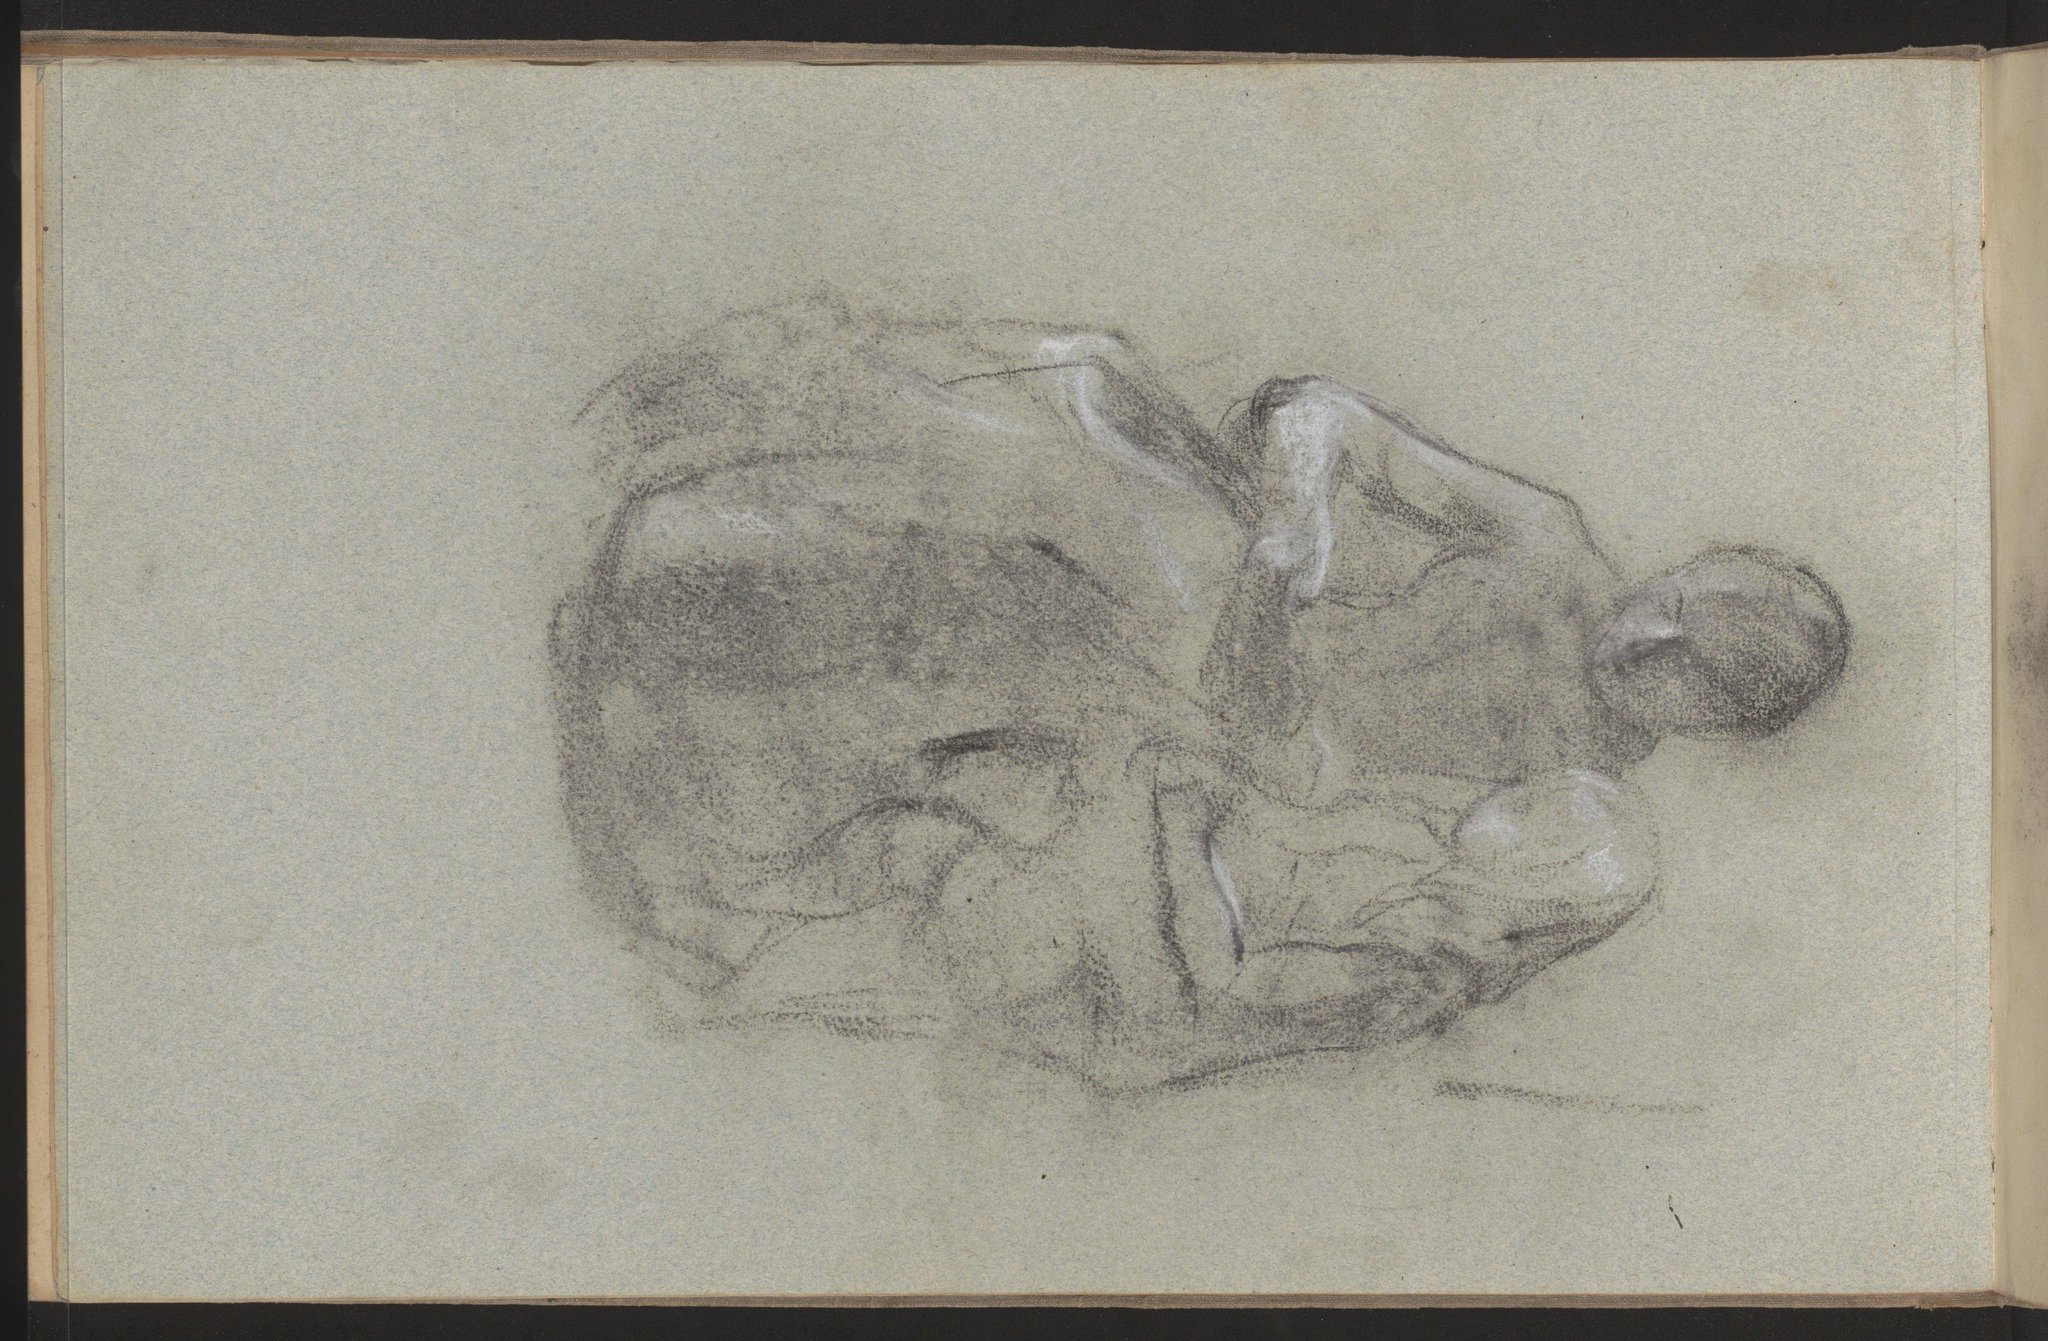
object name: sketchbook leaf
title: Moeder met een meisje op schoot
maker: albert neuhuys (1844-1914)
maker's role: draughtsman, painter, print maker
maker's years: 1844-1914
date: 1854-1914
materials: charcoal, paint, paper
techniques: brush, stumping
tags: mother and child(ren), woman and child(ren) (family group)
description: Blad 38 verso uit een schetsboek met 51 bladen.